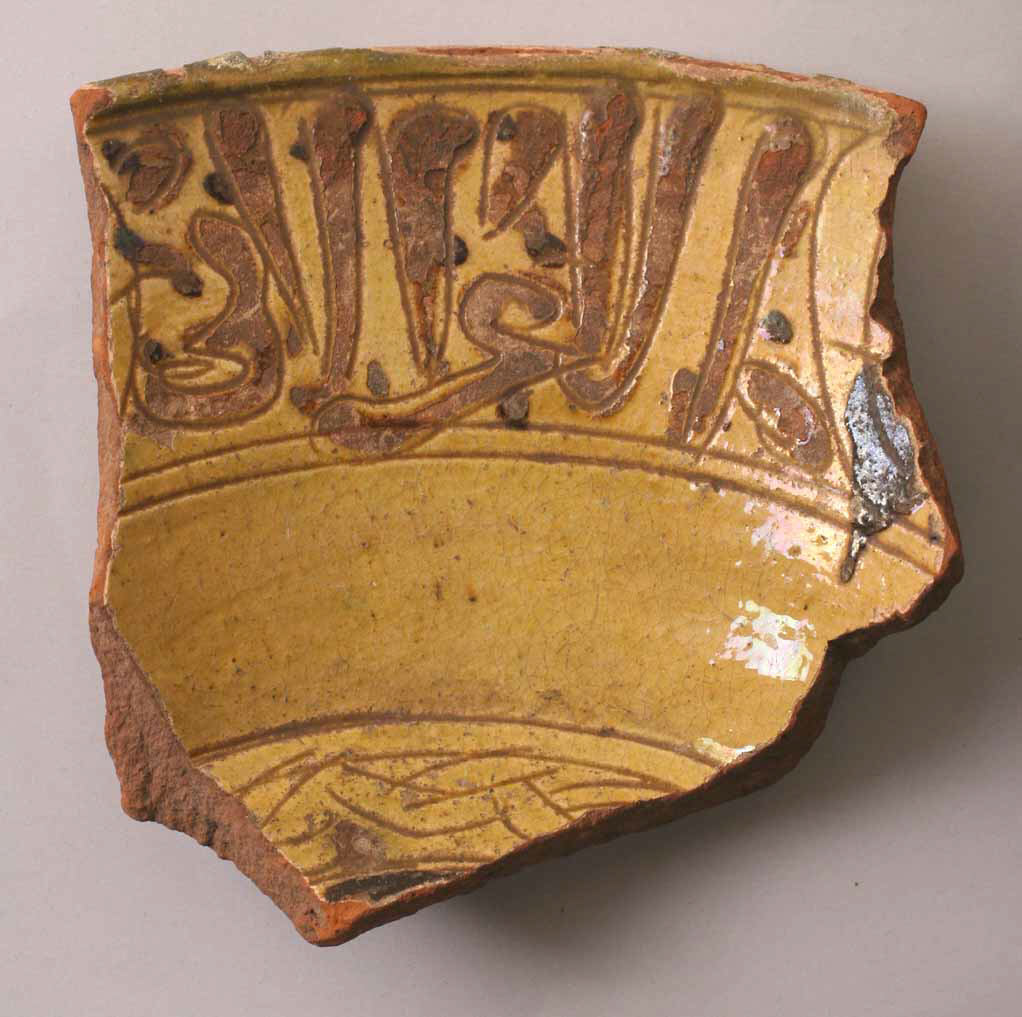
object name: fragment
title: Fragment of a Bowl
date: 1301-1500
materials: earthenware, glaze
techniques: coloring, incising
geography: egypt